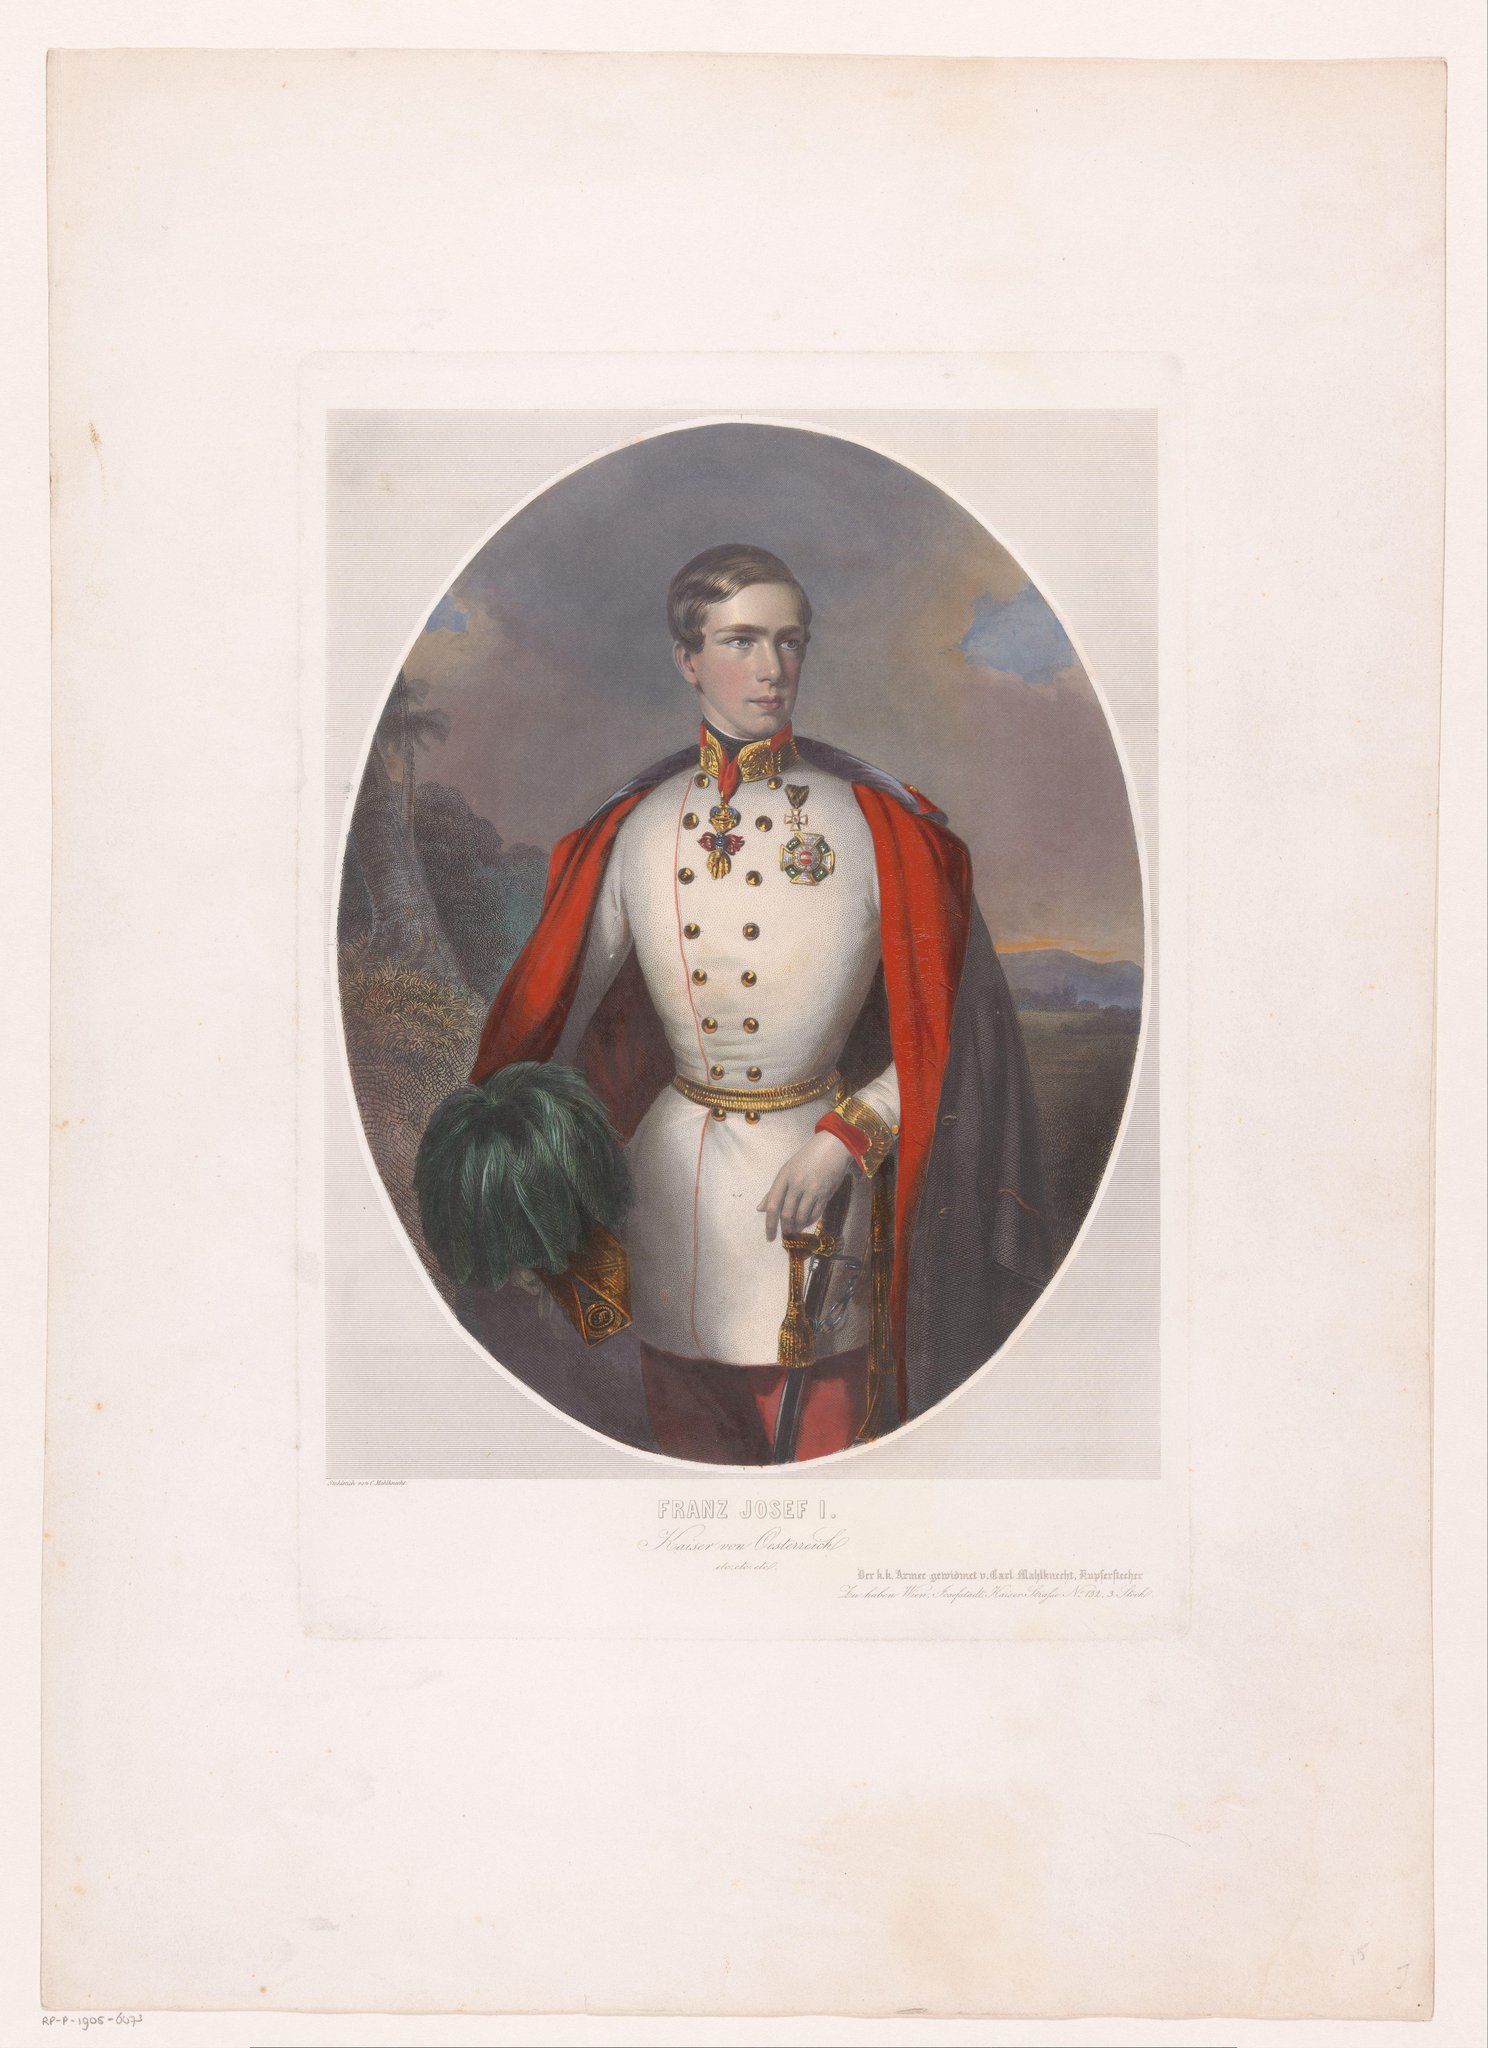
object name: print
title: Portret van Frans Jozef I van Oostenrijk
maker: karl mahlknecht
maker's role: print maker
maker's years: 1810-1893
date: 1820-1893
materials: paper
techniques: hand coloring, engraving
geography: vienna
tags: vienna, historical persons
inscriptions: collector's mark: Lugt 2228, stamp: ‘Carl Mahlknecht’